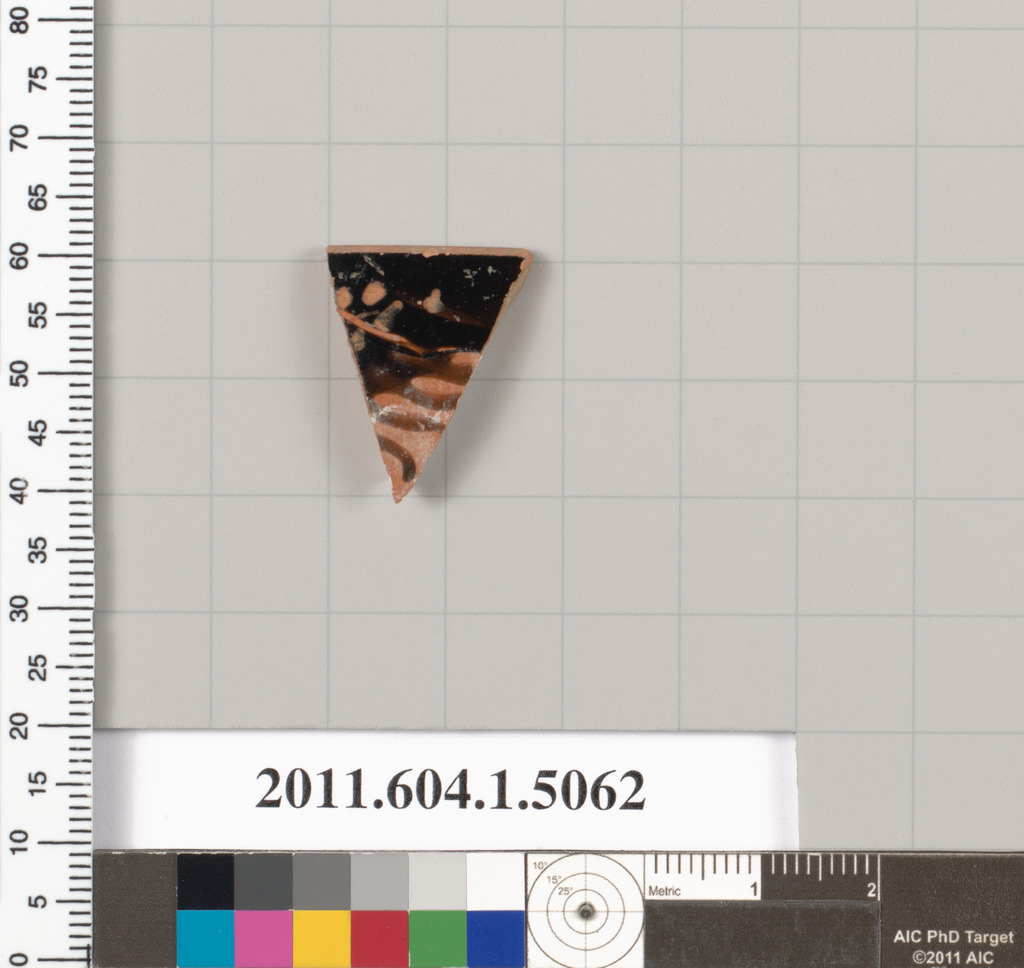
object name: kylix fragment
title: Terracotta rim fragment of a kylix (drinking cup)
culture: greek, attic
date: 510-500 BCE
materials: terracotta